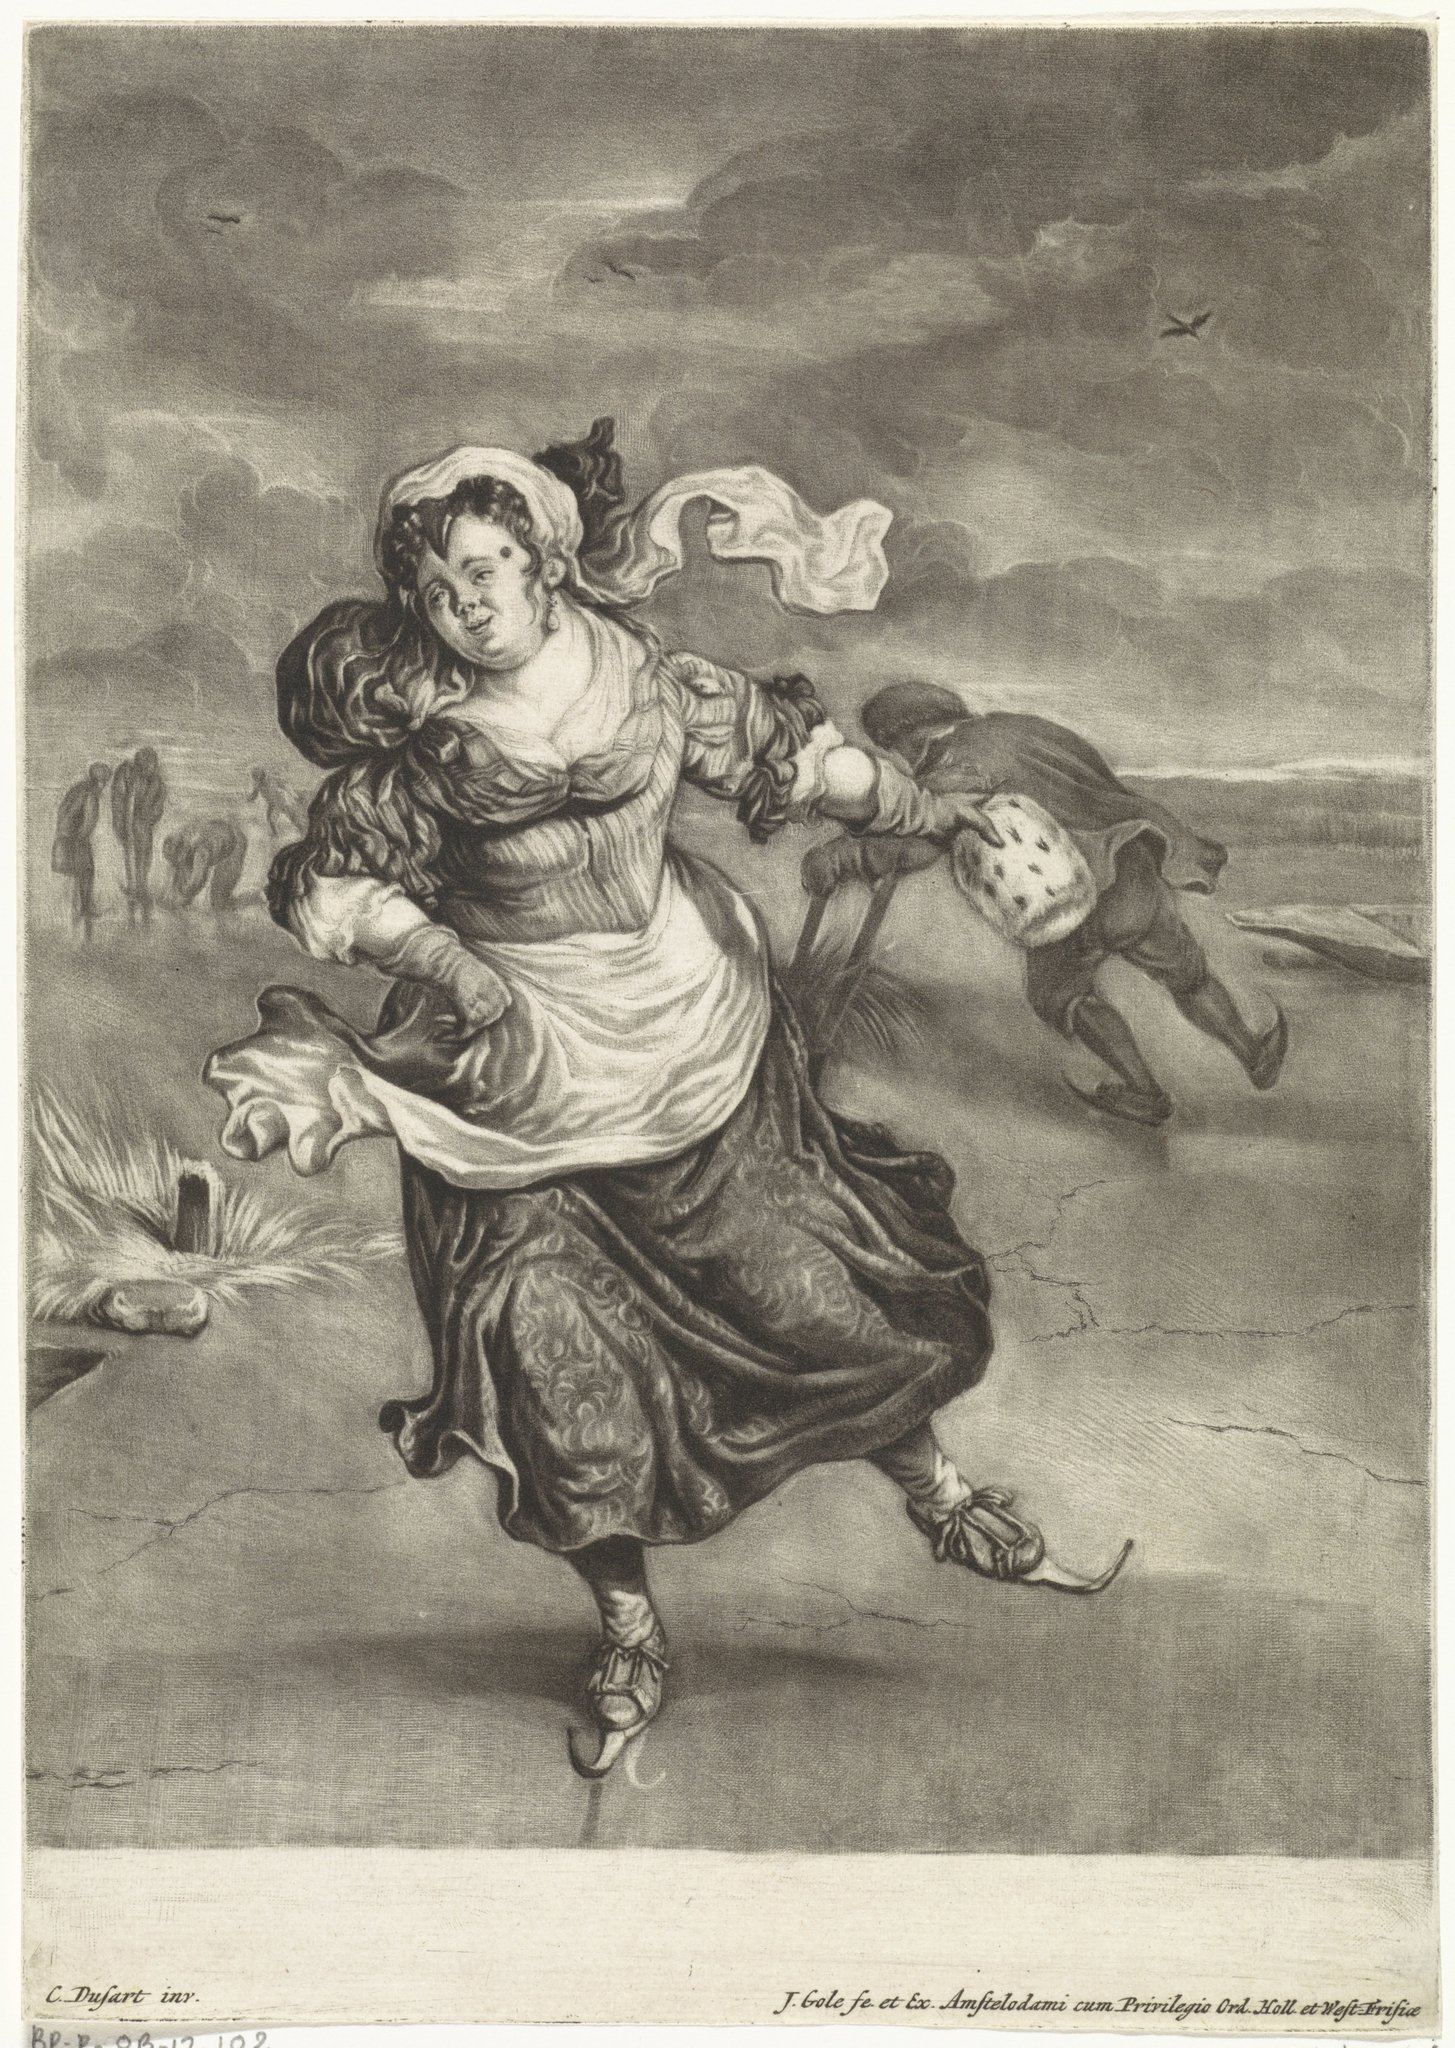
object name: print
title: Schaatsende vrouw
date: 1670-1724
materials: paper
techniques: engraving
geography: amsterdam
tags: adult woman, muff, skates (winter sports)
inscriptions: collector's mark: Lugt 240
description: Een vrouw schaatst over het ijs, haar rokken wapperen in de wind. In de hand heeft ze een mof. Achter haar een schaatser en enkele figuren bij een wak.